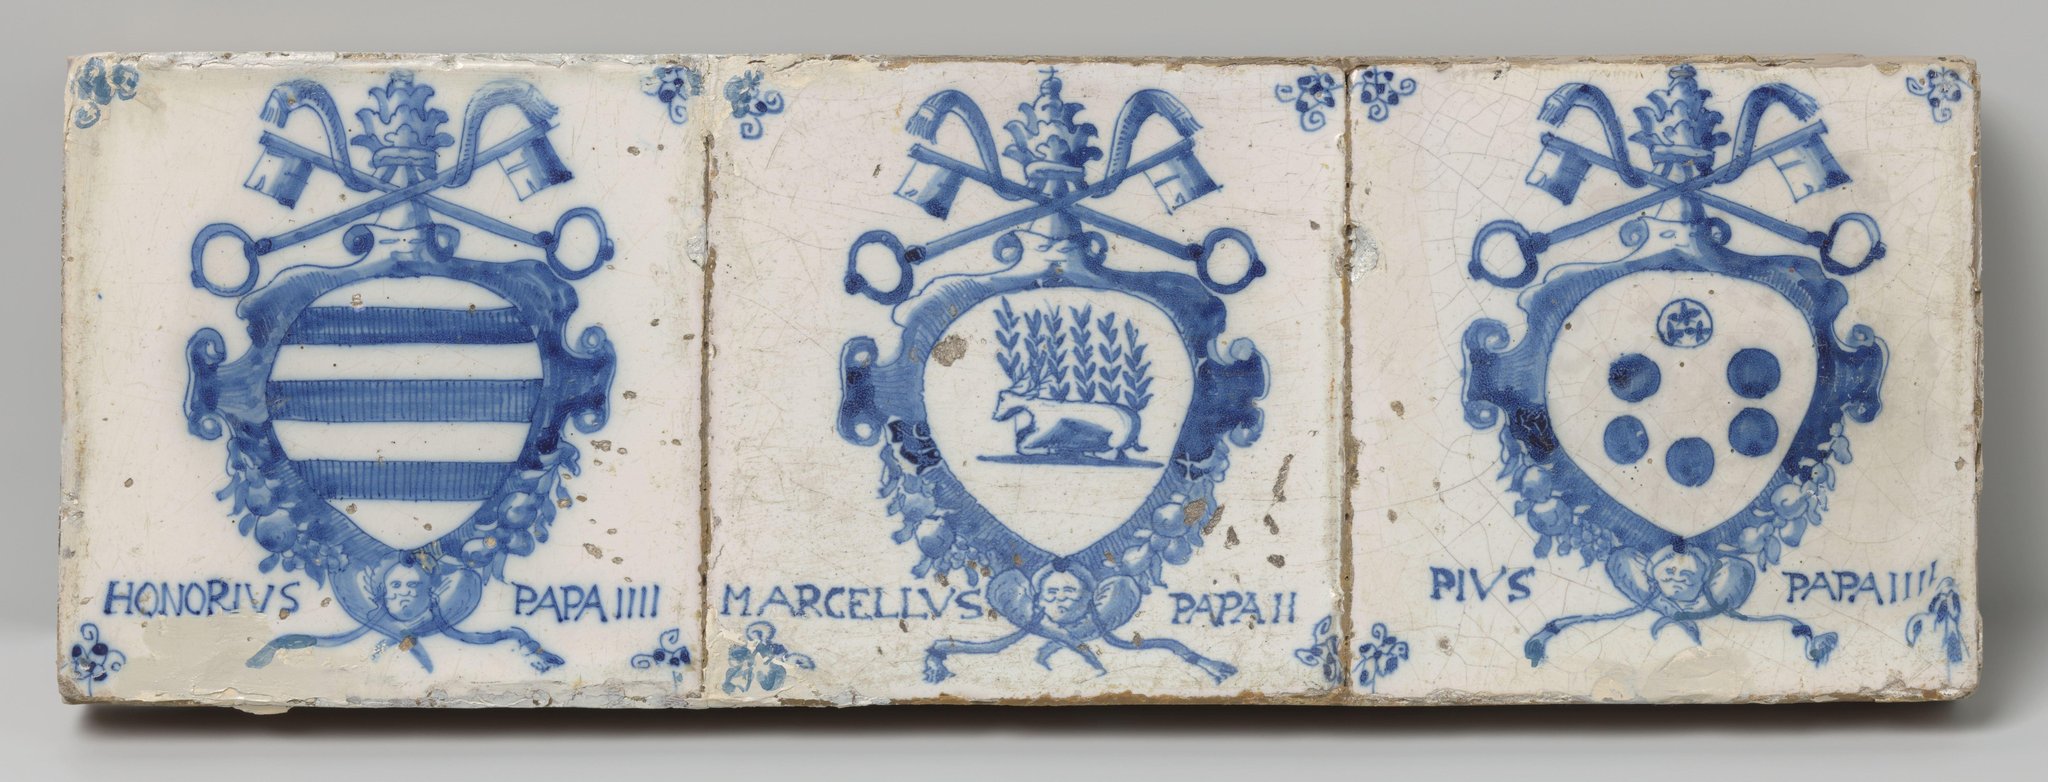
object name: tile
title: Veld van drie tegels met pausen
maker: Anonymous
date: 1650-1680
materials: earthenware, glaze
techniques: maiolica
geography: netherlands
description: Veld van drie tegels (1 x 3) elk met een blauw geschilderd wapen vaan een paus met onderaan het opschrift: HONORIVS PAPA IIII, MARCELLVS PAPA II of PIVS PAPA IIII. In de hoeken, een spinnetje.